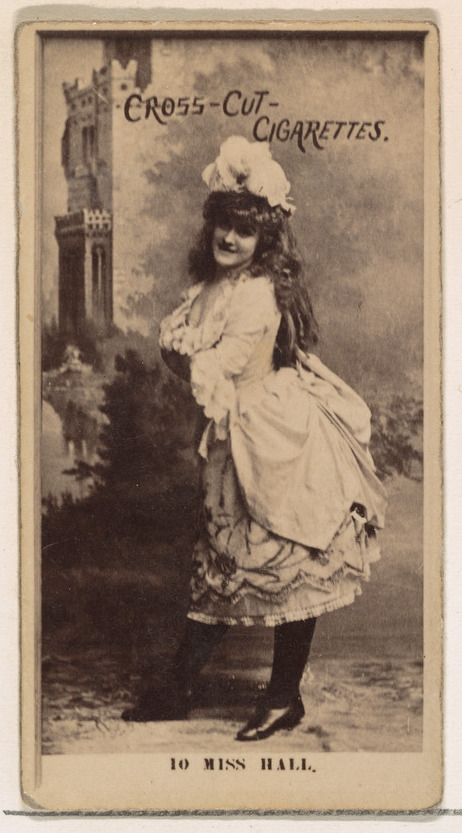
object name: print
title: Card Number 10, Miss Hall, from the Actors and Actresses series (N145-2) issued by Duke Sons & Co. to promote Cross Cut Cigarettes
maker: w. duke, sons & co.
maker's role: publisher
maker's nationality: american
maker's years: 1870-1920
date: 1880-1889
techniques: albumen silver print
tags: portraits,women,actresses